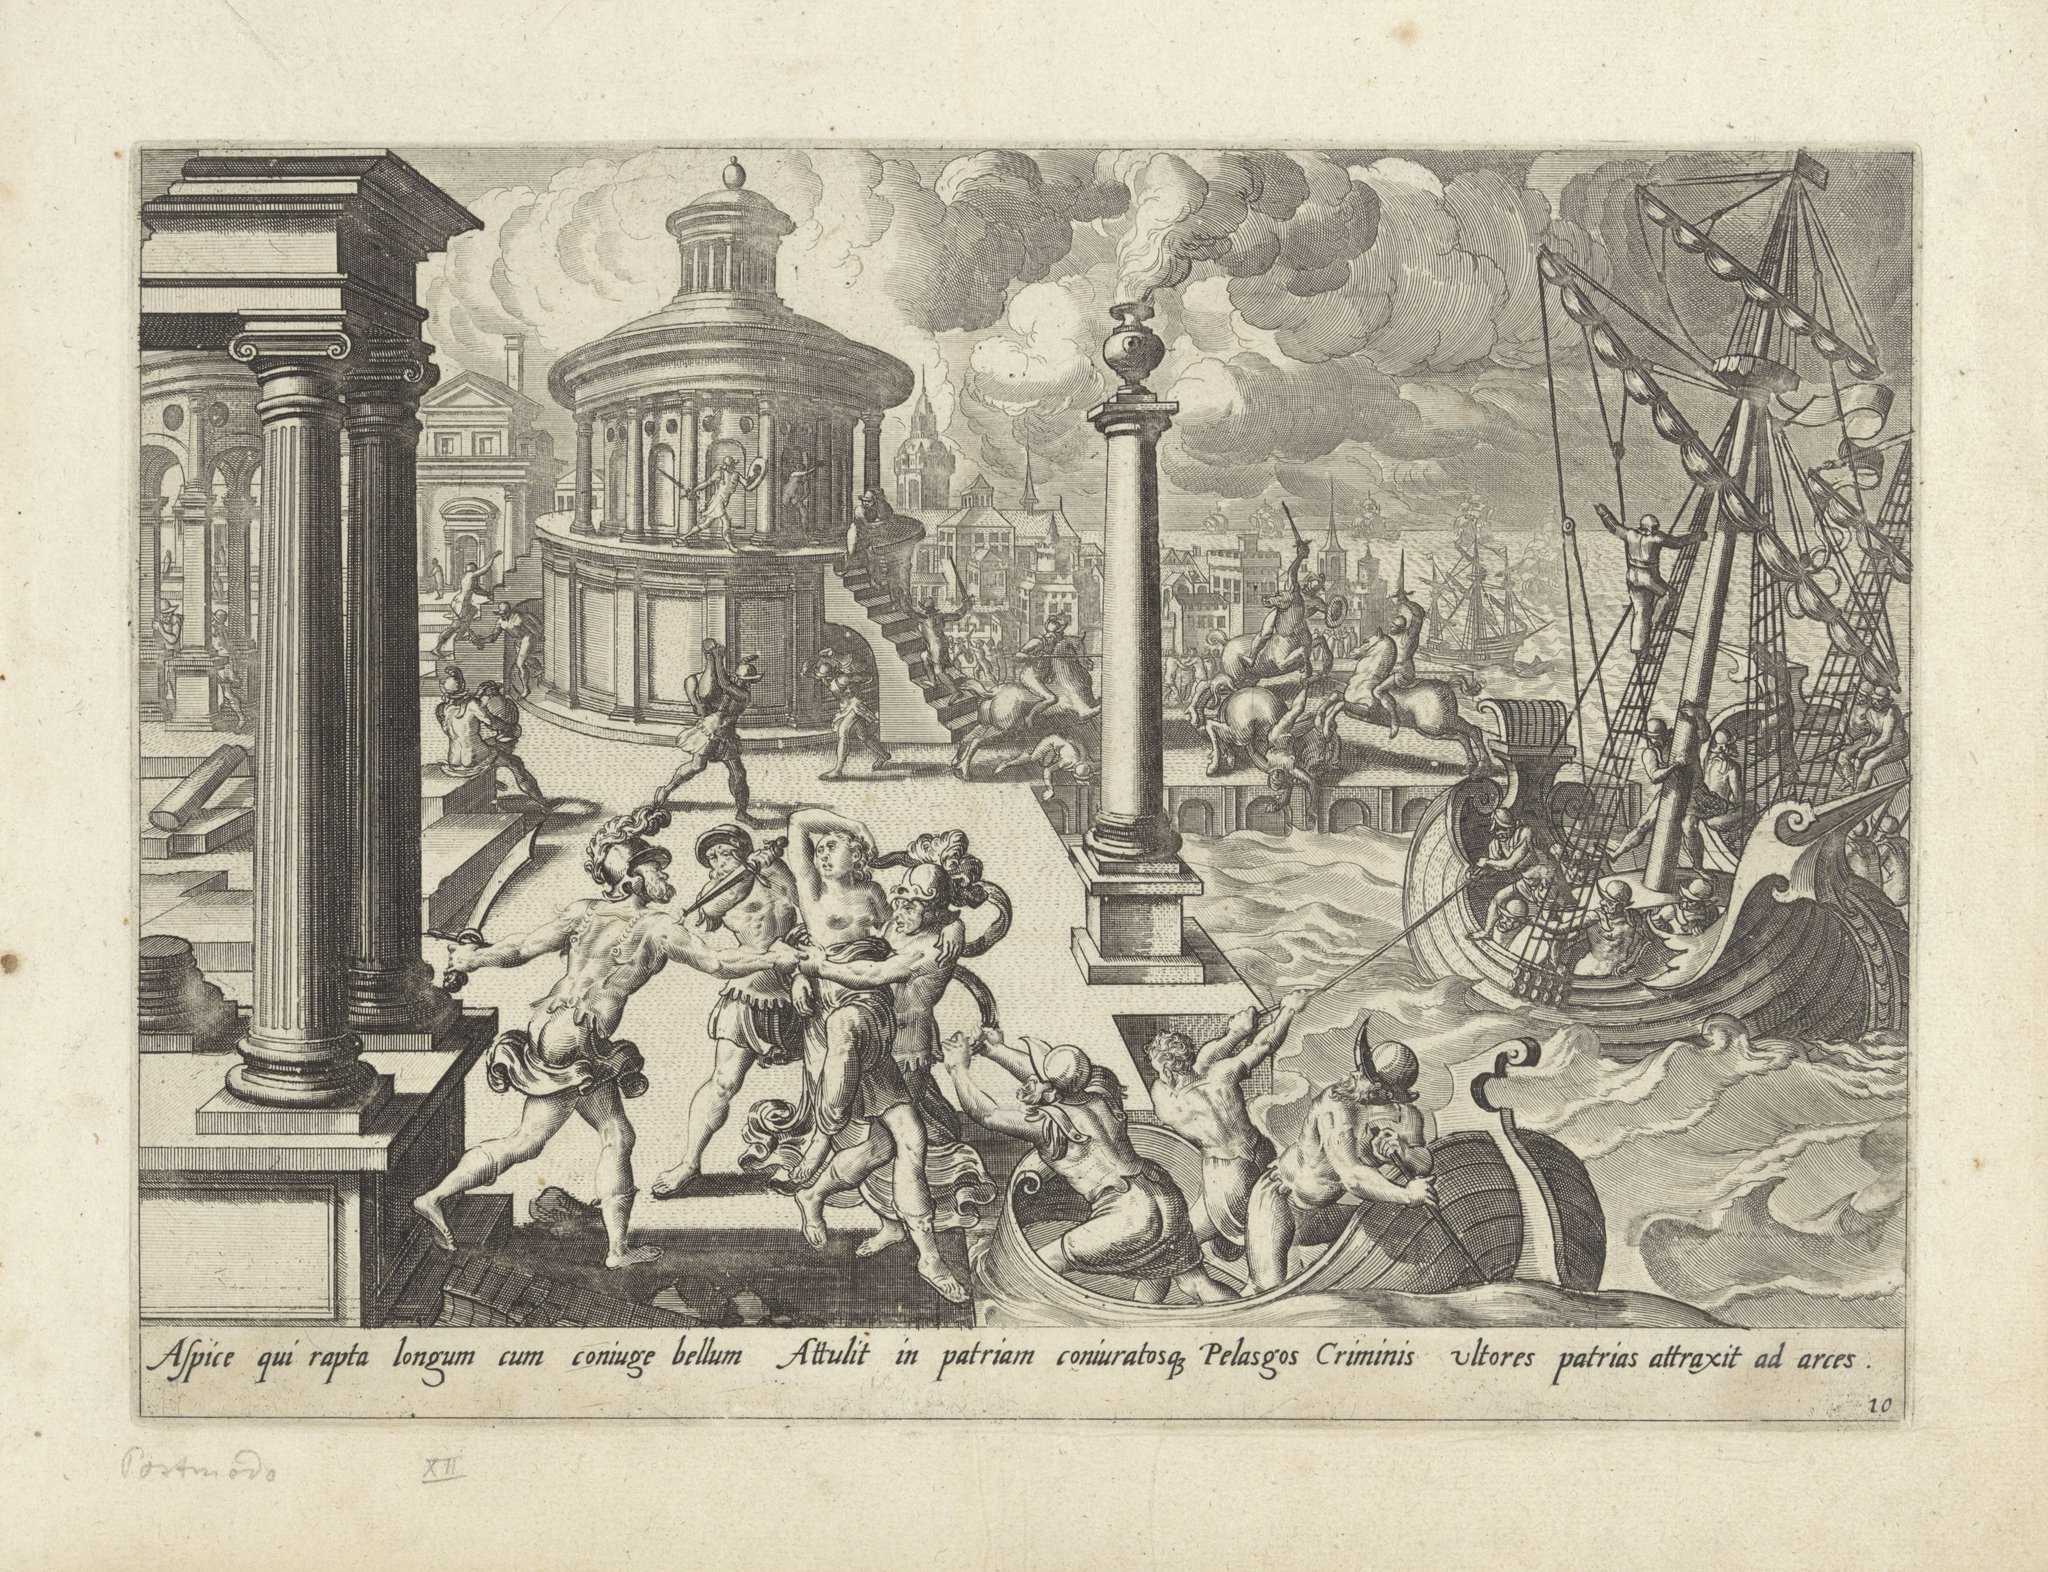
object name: print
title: Metamorfosen van Ovidius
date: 1601-1652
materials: paper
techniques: etching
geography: antwerp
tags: sailing-ship, sailing-boat, the abduction of helen and some of her companions: paris carries them off by sea, and takes a part of the palace-treasure with him, battle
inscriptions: collector's mark: Lugt 2228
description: Haven met de roof van Helena. Helena wordt door twee mannen naar een boot gevoerd. Onder de voorstelling de tekst uit de Metamorfosen van Ovidius, boek 12, versregels 5-6.